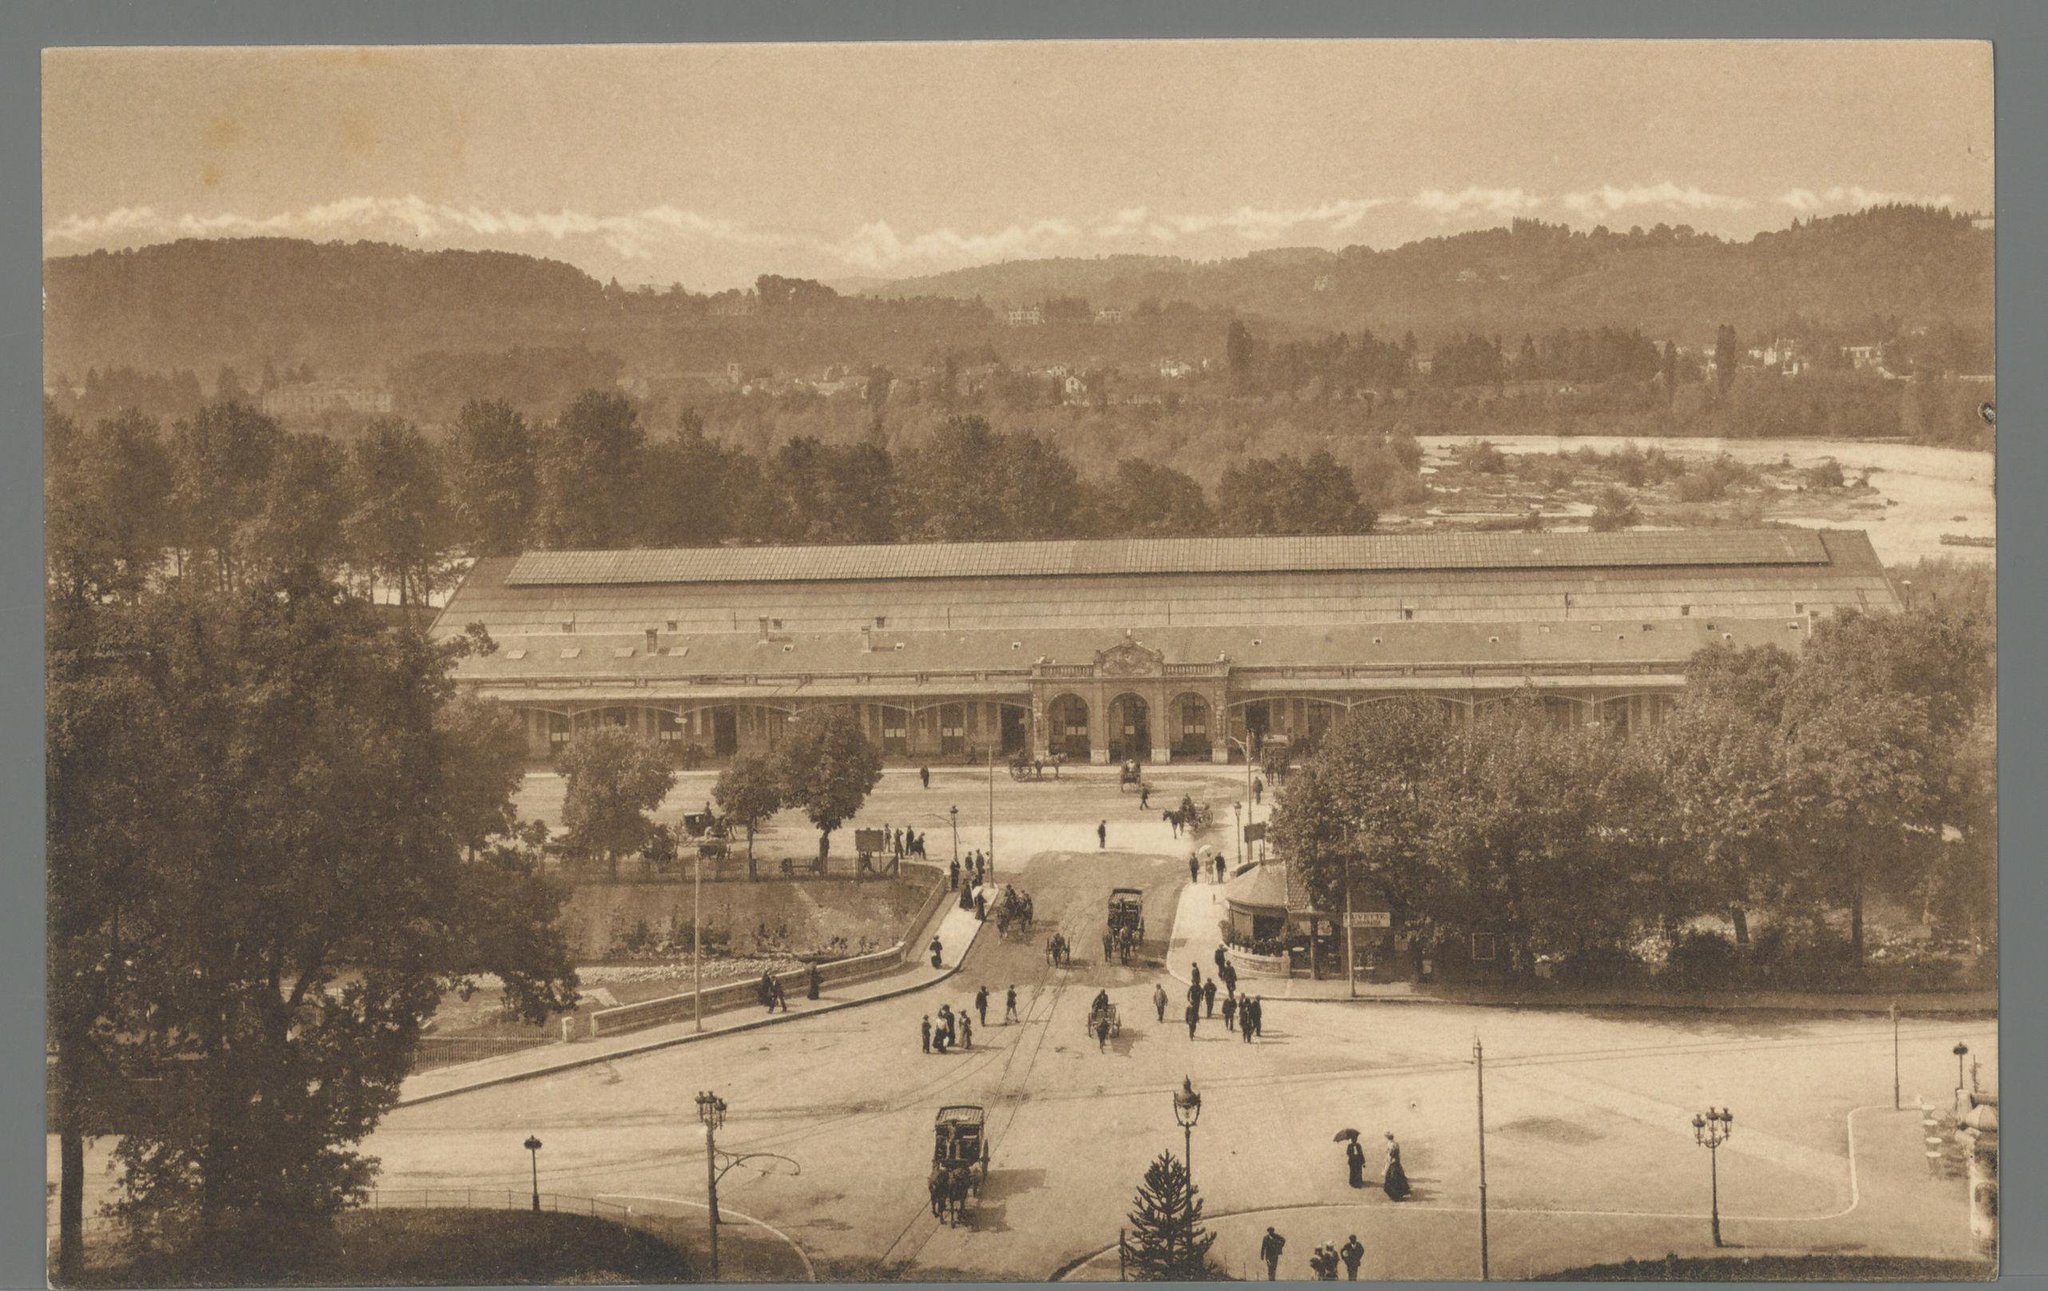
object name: ansichtkaart, prentbriefkaart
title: Pau. La Gare, vue générale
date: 1904-1906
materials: cardboard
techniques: photograph, writing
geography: pau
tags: station; shelter (railway, tramway), mountains